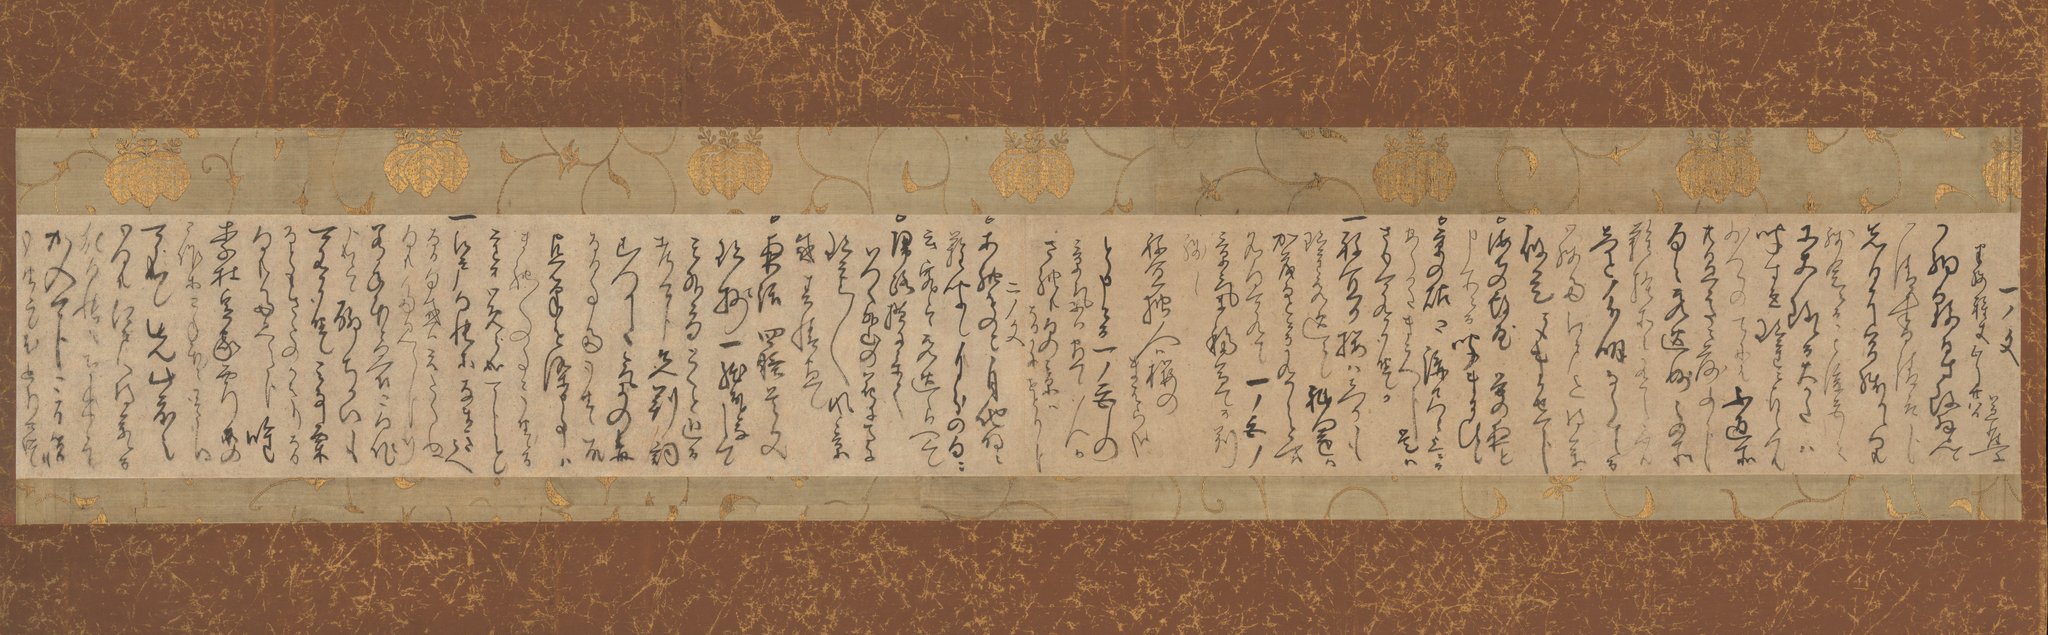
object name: hanging scroll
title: Letter to Yamagishi Hanzan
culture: japanese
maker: matsuo bashō 松尾芭蕉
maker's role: artist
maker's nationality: japanese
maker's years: 1644-1694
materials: ink, paper